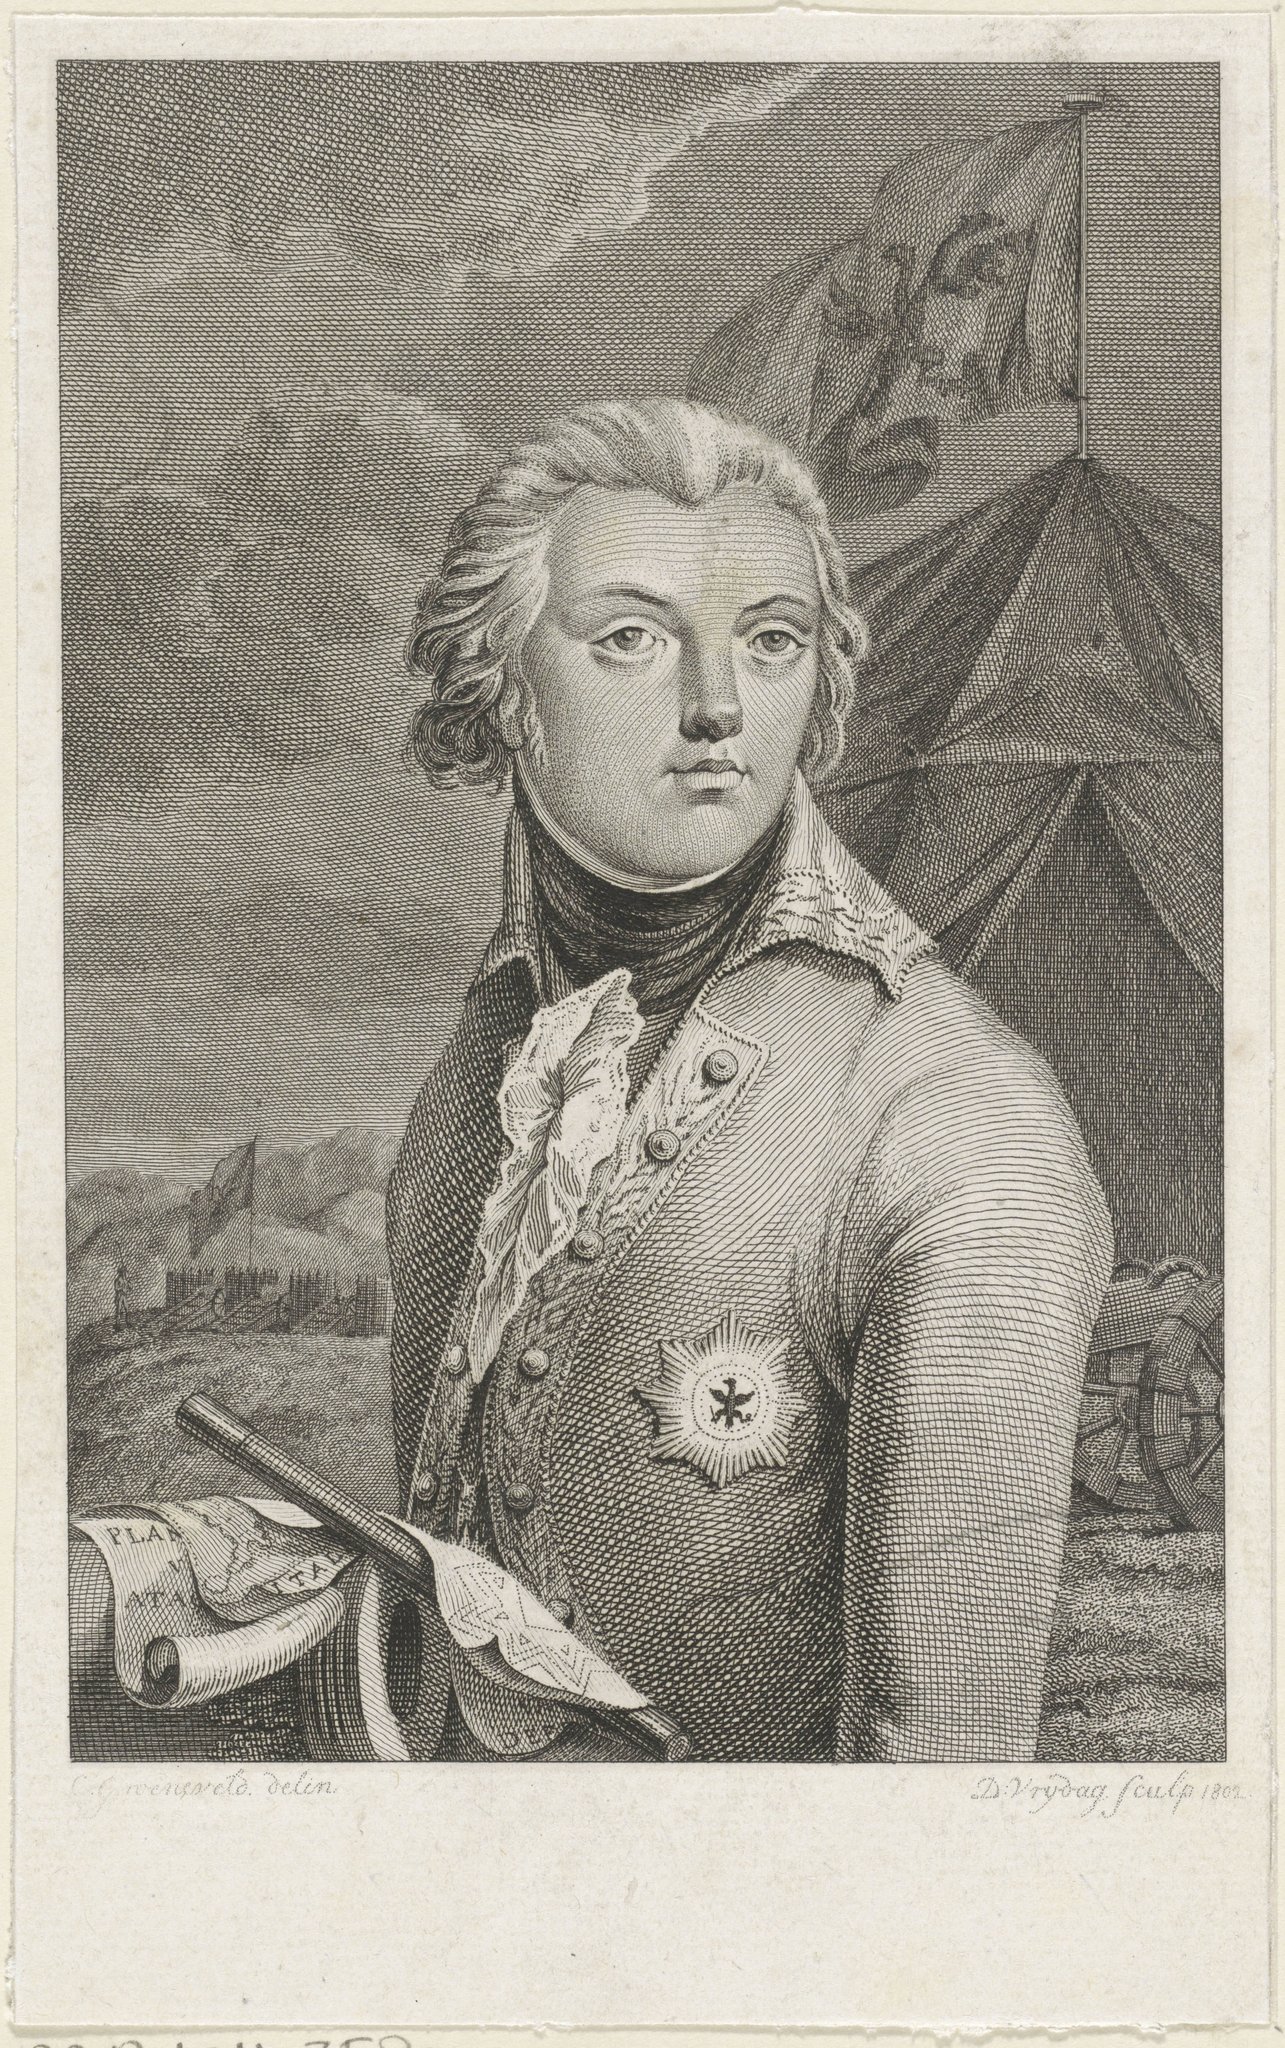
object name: print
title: Portret van Frederik, prins van Oranje-Nassau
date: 1802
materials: paper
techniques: engraving, etching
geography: northern netherlands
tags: the hague, willem george frederik (prins van oranje-nassau), knighthood order (with name) - insignia of a knighthood order, e.g.: badge, chain (with name of order)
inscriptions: collector's mark: Lugt 2228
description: De hier vermelde titel verwijst naar de hoogst verkregen titel van de geportretteerde, niet per se naar de titel die de geportretteerde op deze voorstelling draagt.